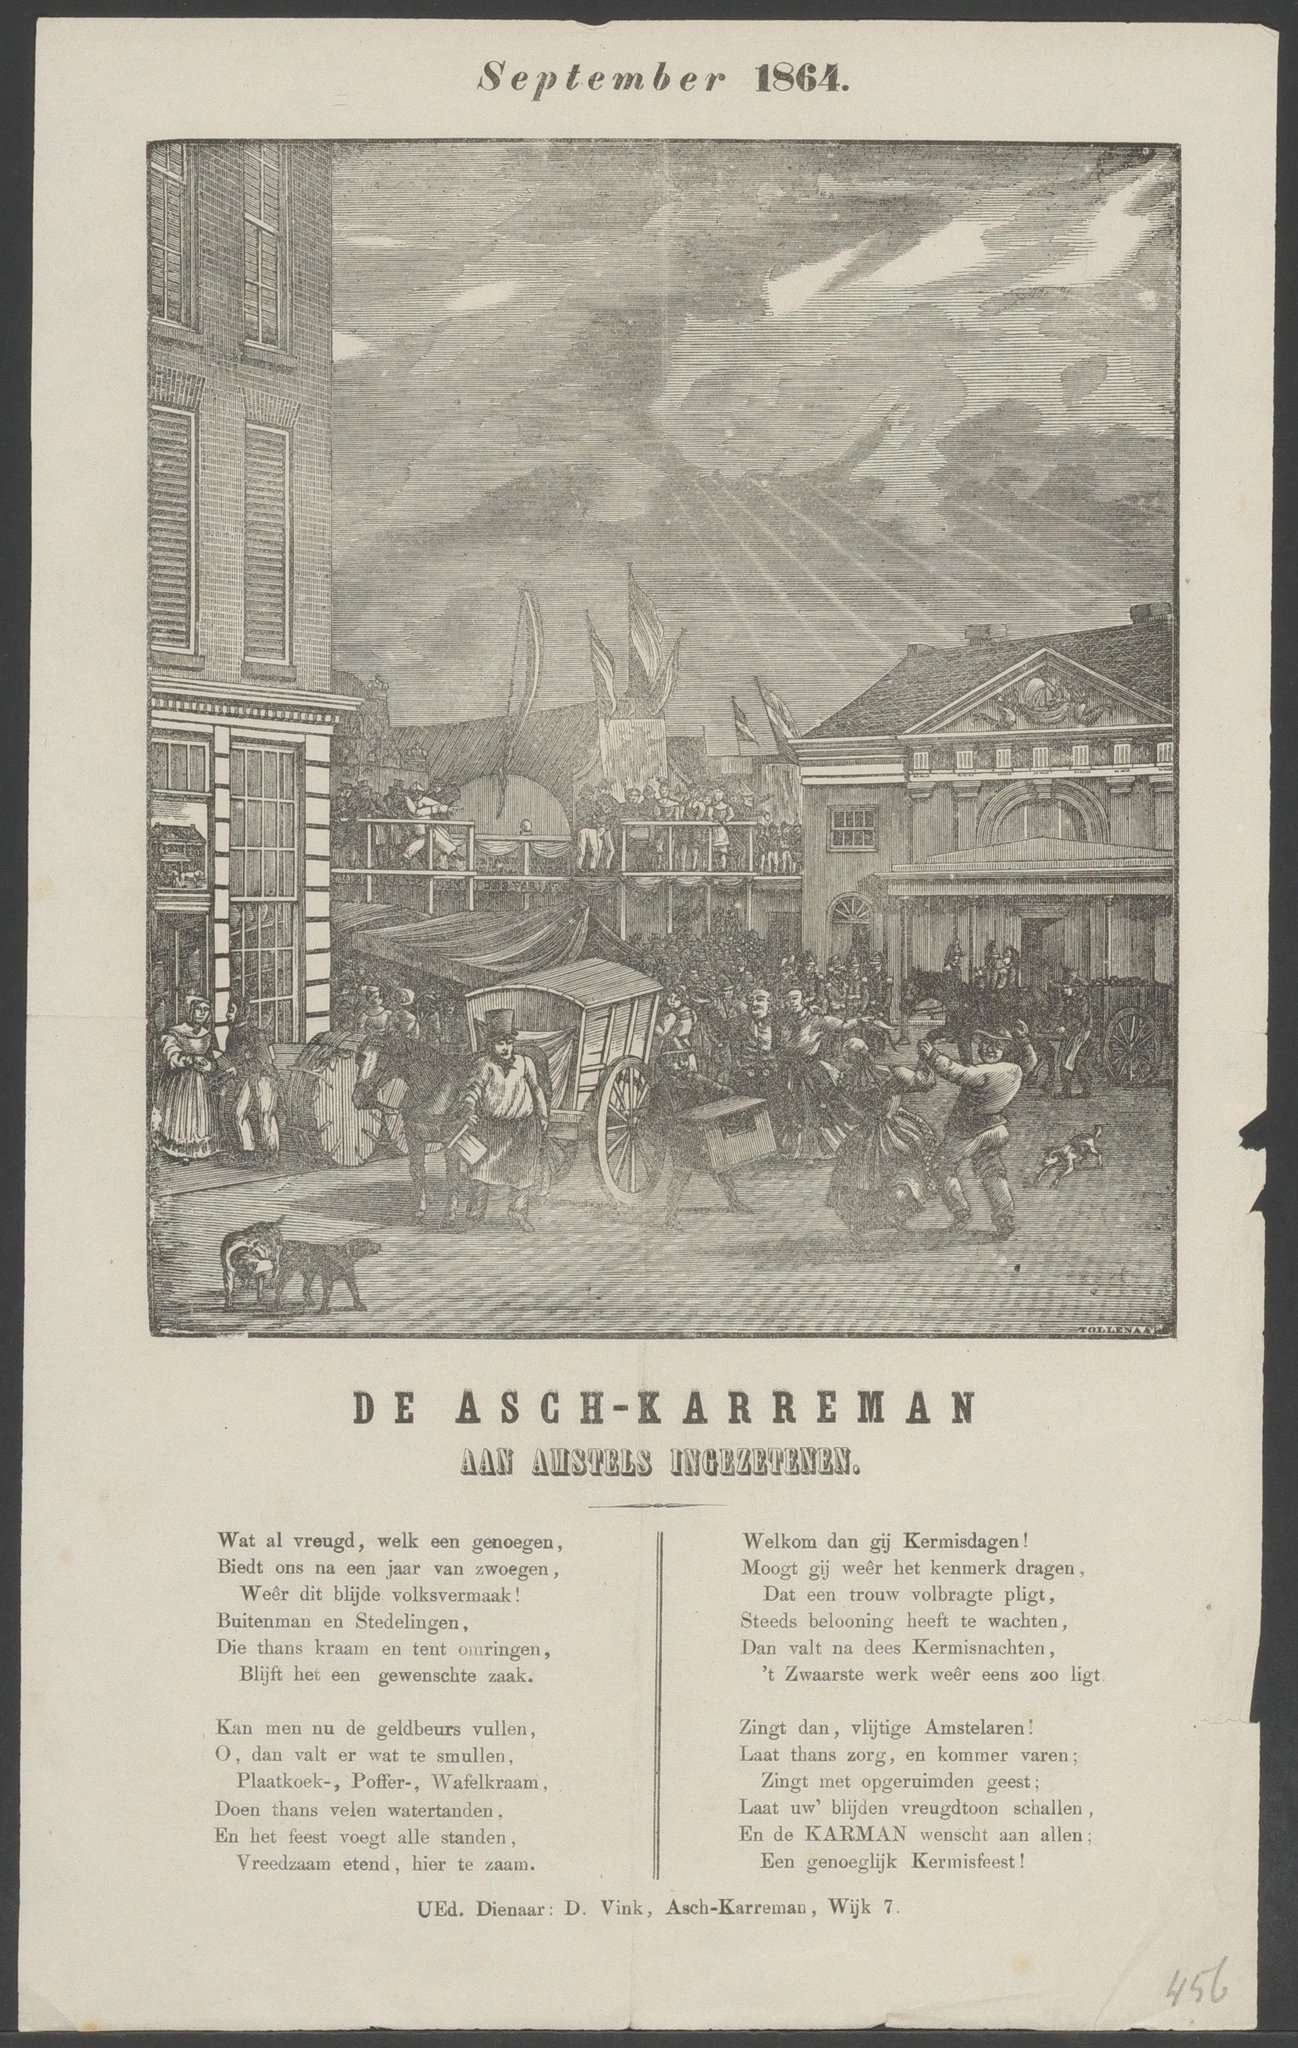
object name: print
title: Asch-Karmans kermis-wensch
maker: dirk wijbrand tollenaar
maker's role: print maker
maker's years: 1808-1858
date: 1864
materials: paper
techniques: letterpress printing, engraving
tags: pleasure fair and circus, garbage collection, amsterdam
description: Kermisprent namens de askarrenmannen (karrenman of vuilnisman) te Amsterdam, september 1864. Gezicht op de kermis op de Botermarkt met de Regulierswaag. Op de markt twee vuilniskarren. Onderaan een gedicht in twee kolommen. Namens D. Vink, de askarreman van wijk no. 7. Onderwerpsrubrieken binnen de Atlas Zeden en Gewoonten: Zeden en gewoonten in engeren zin, Volksleven, Volksbladen, Nieuwjaars- en Kerstwenschen, Amsterdam.